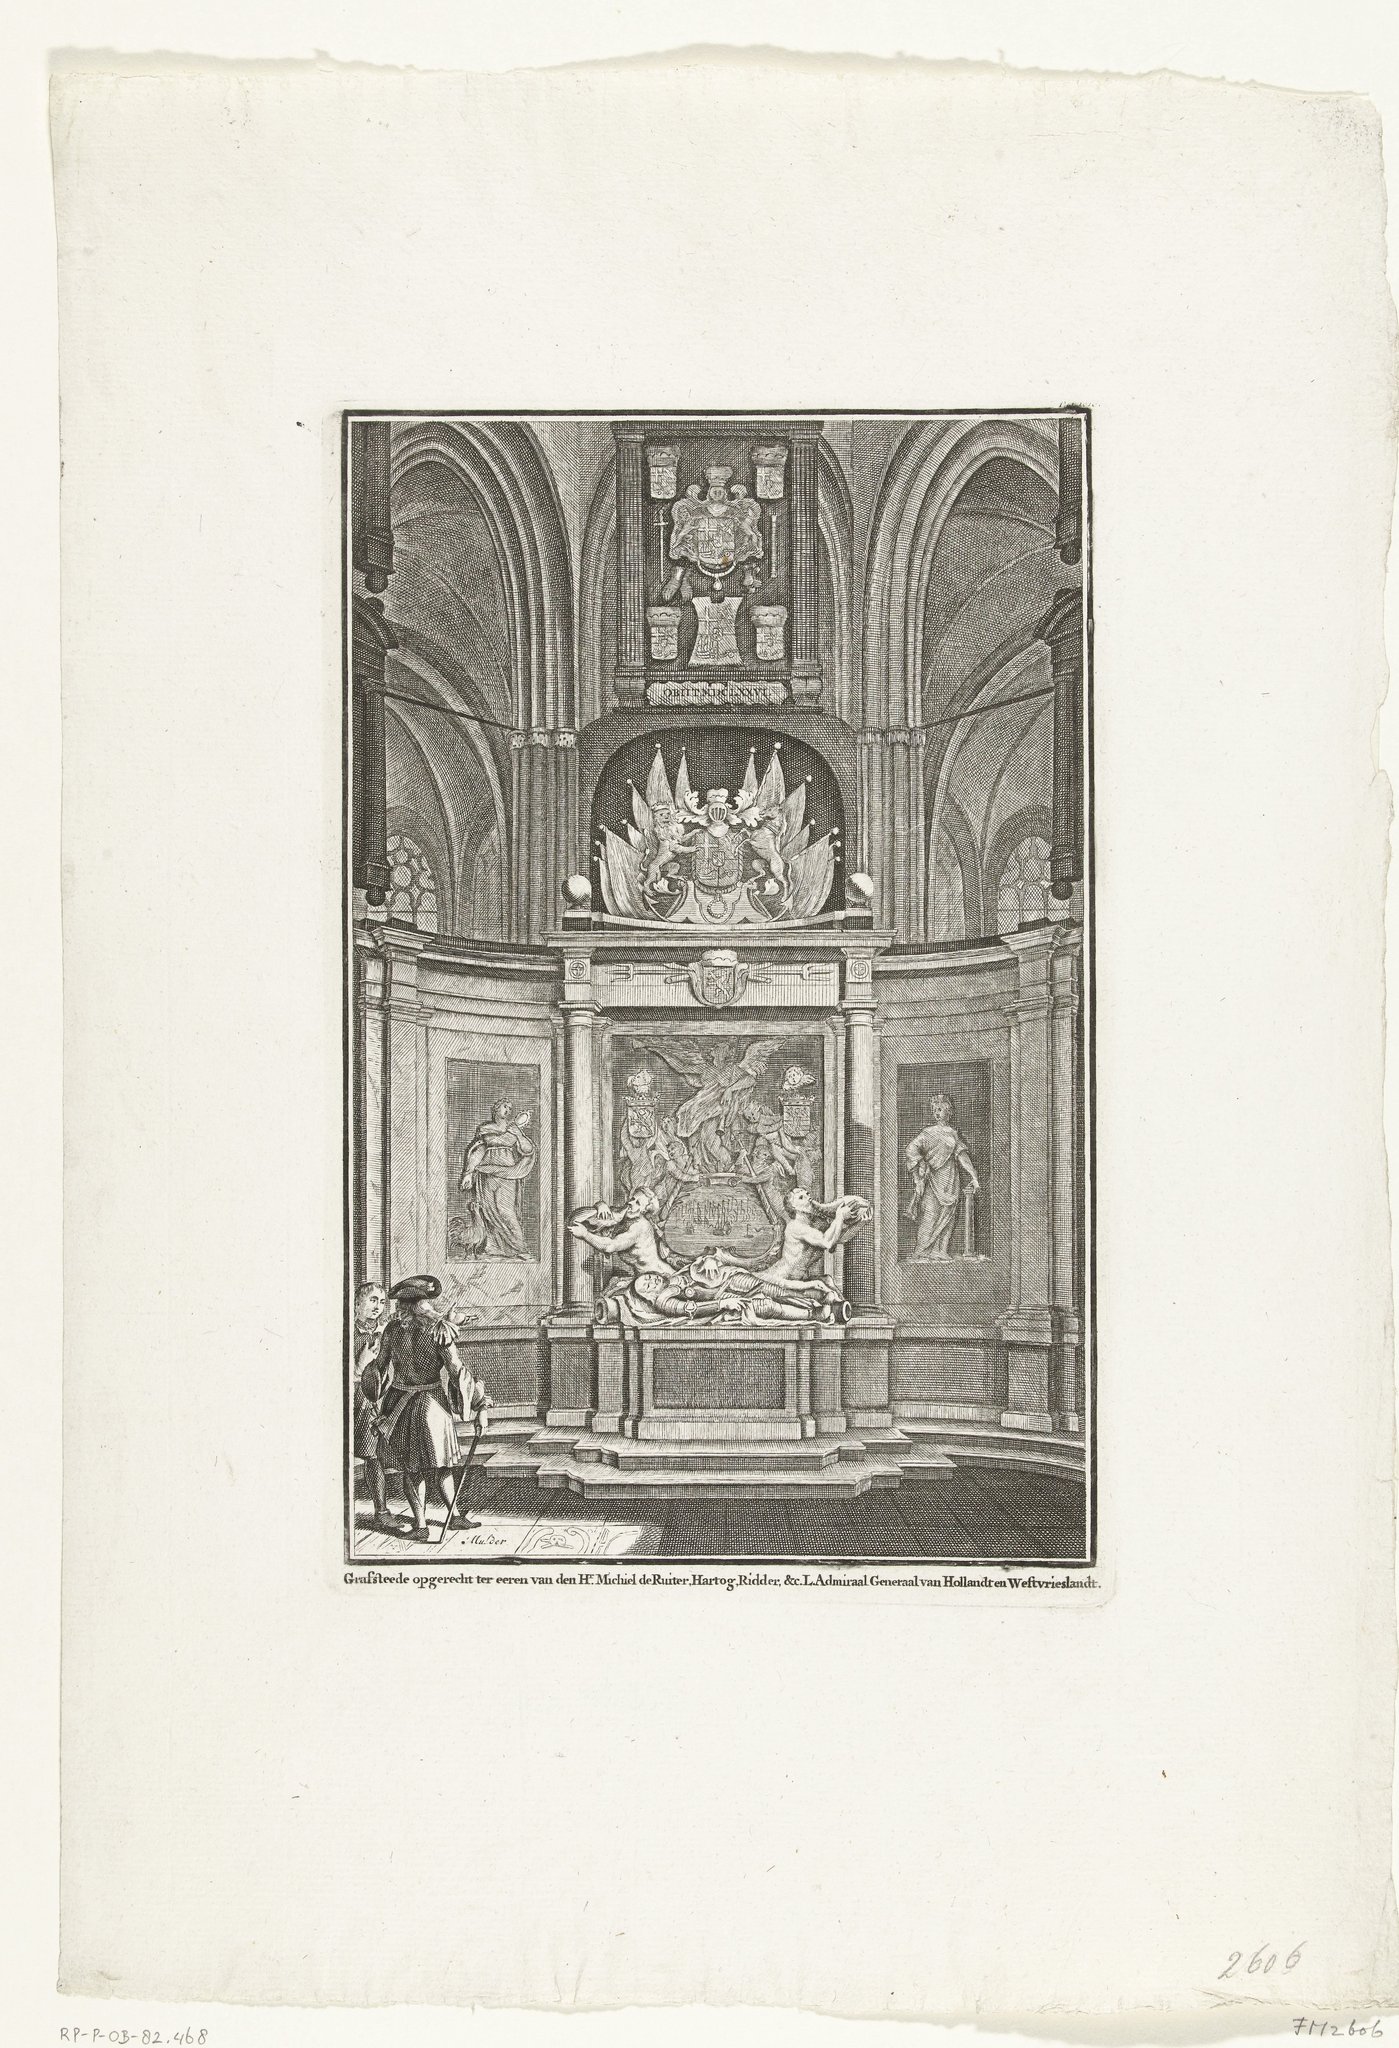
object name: book illustration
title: Grafsteede opgerecht ter eeren van den Hr. Michiel de Ruiter, Hartog, Ridder, &c. L. Admiraal Generaal van Hollandt en Westvrieslandt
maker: joseph mulder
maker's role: print maker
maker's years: 1658-1718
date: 1687-1726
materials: paper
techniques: engraving, etching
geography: amsterdam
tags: flushing, michiel adriaenszoon de ruyter, interior of church, grave-building, monumental tomb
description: Het praalgraf van Michiel Adriaenszoon de Ruyter in het koor van de Nieuwe Kerk te Amsterdam. De luitenant-admiraal-generaal van Holland en West-Friesland werd er op 18 maart 1677 begraven. Links twee bezoekers. Rechtsboven gemerkt: Pag. 1010.